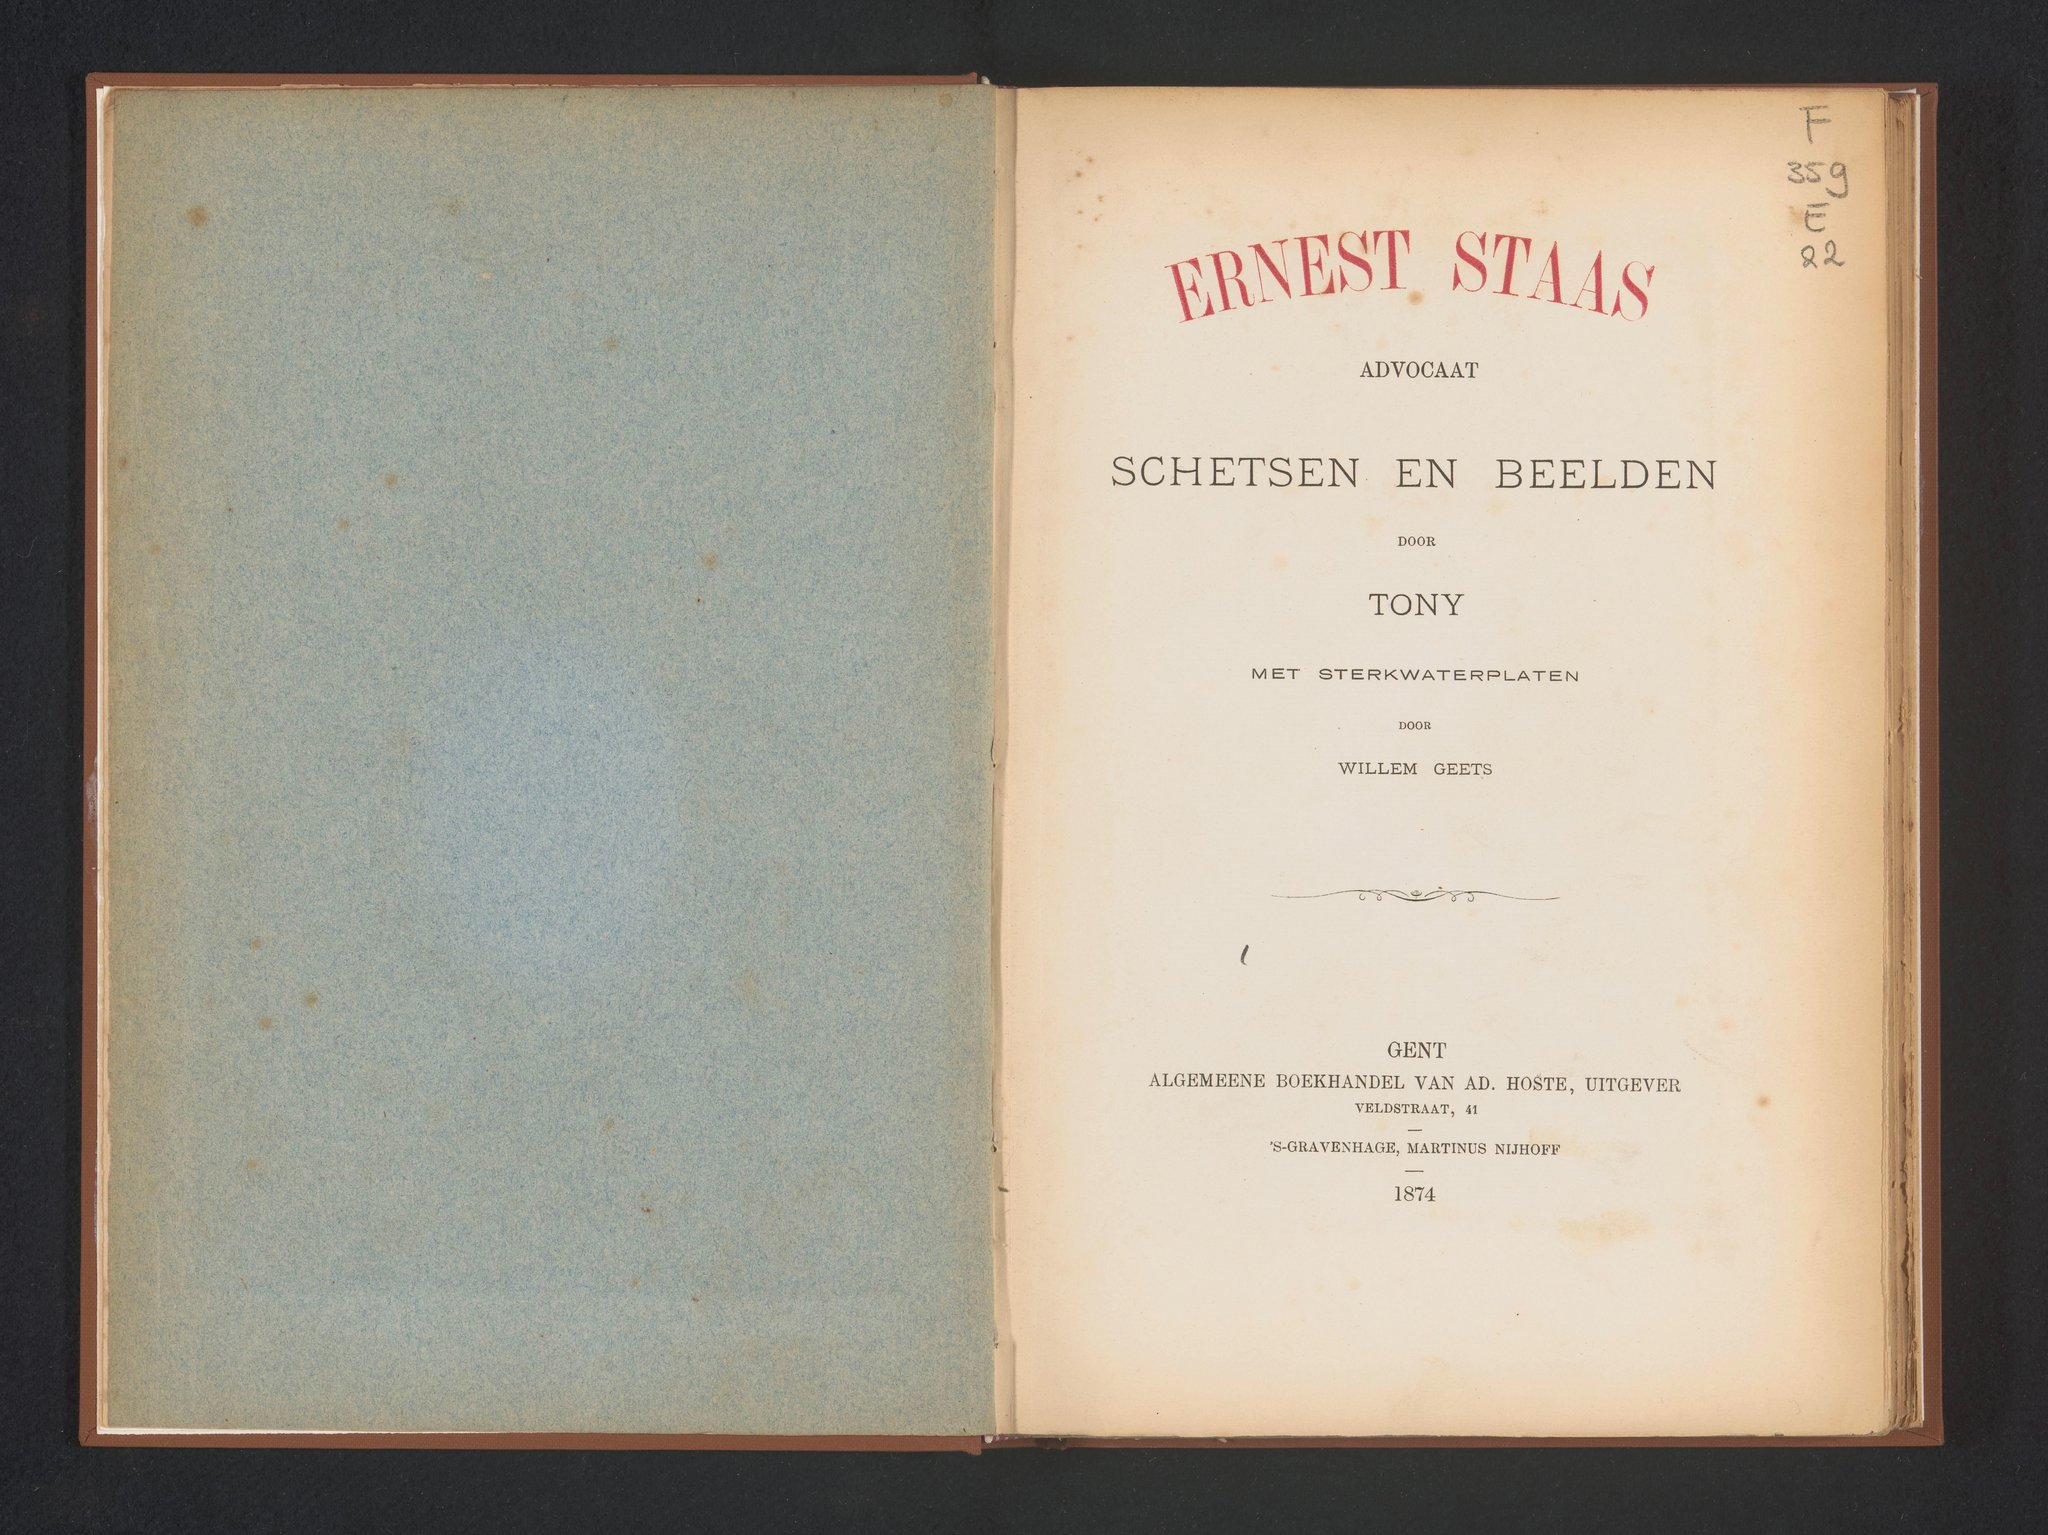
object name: book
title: Ernest Staas, advocaat : schetsen en beelden / door Tony (Anton Bermann); met sterkwaterplaten door Willem Geets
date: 1874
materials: cardboard, leather, linen, paper, photographic support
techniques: albumen print, etching, printing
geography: ghent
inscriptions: annotation: ‘Met 15 etsen, + ori. foto-portret/ van de schrijver (Tony = Anton Bergmann,/ 1835-1874)/ Belangrijkste werk vd schrijver, hier in/ eerste uitgave, kort voor zijn dood verschenen./ Exemplaar met opdracht van "Tony" aan Jan t. Brink,/ ook interessant daar gedateerd 1873:/ (als jaar van eerste uitgave/ wordt algemeen 1874 vermeld)’, dedication: ‘Aan mijnen lettervriend/ Doctor Jan ten Brink/ van wege den schrijver/ Tony/ Lier 28 7 1873’